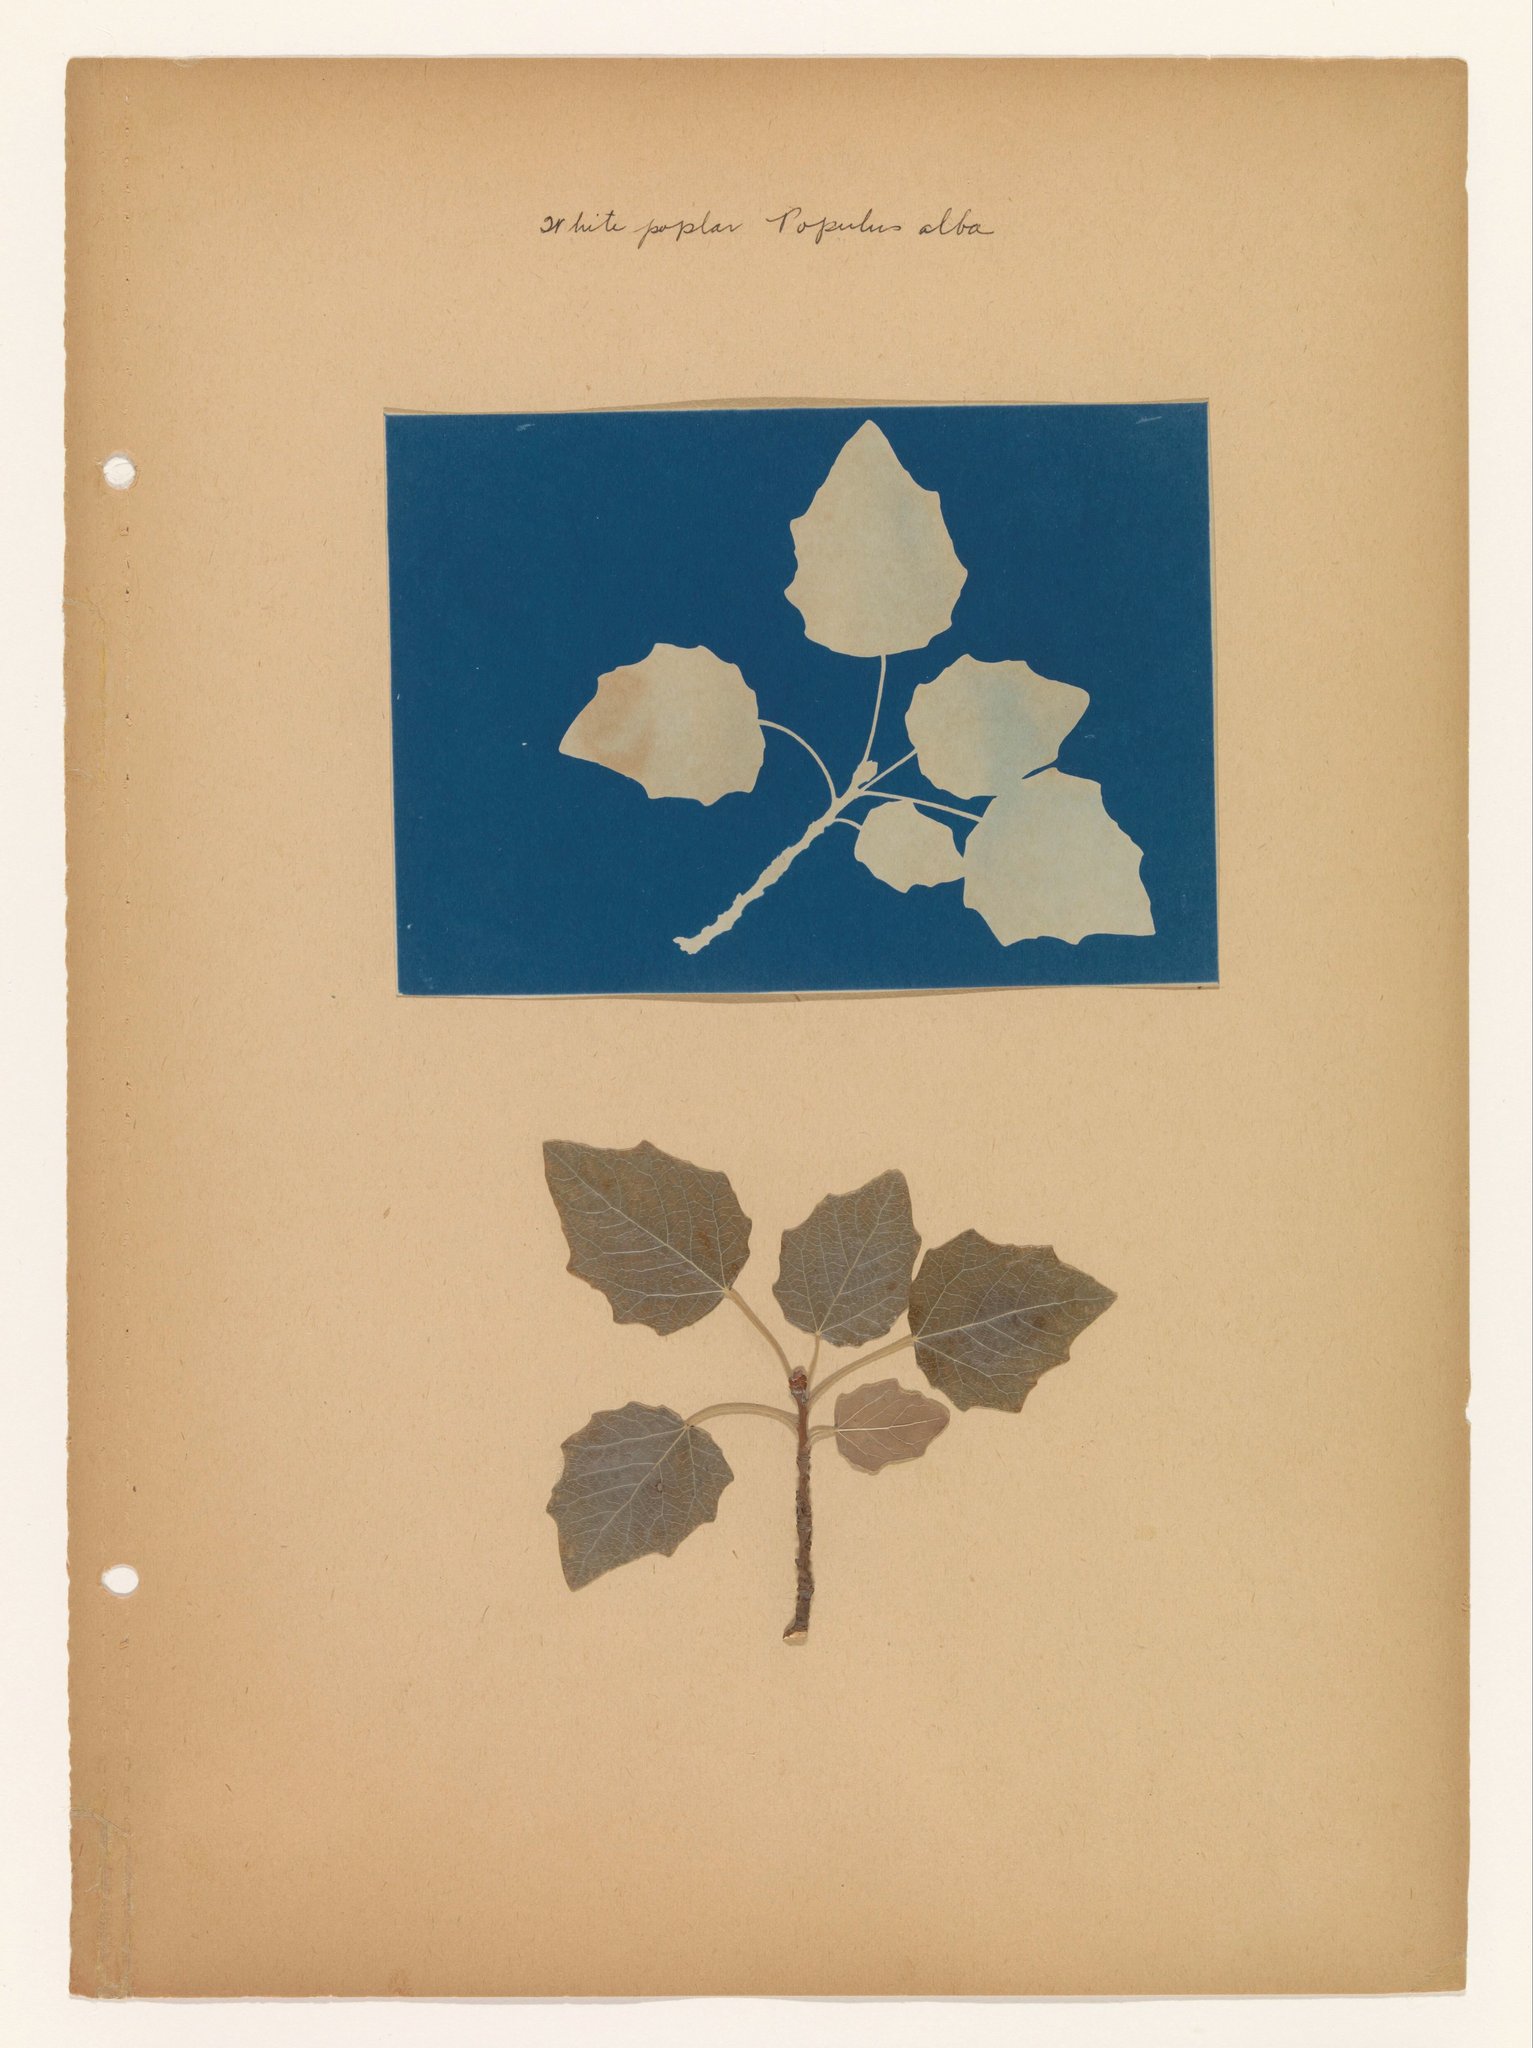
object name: photograph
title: Blad met cyanotypie fotogram van blad van een Witte albeel en het blad zelf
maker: Anonymous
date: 1900-1920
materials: paper, photographic support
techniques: cyanotype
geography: united states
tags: trees (+ leaf)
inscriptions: annotation: ‘White poplar Populus alba’